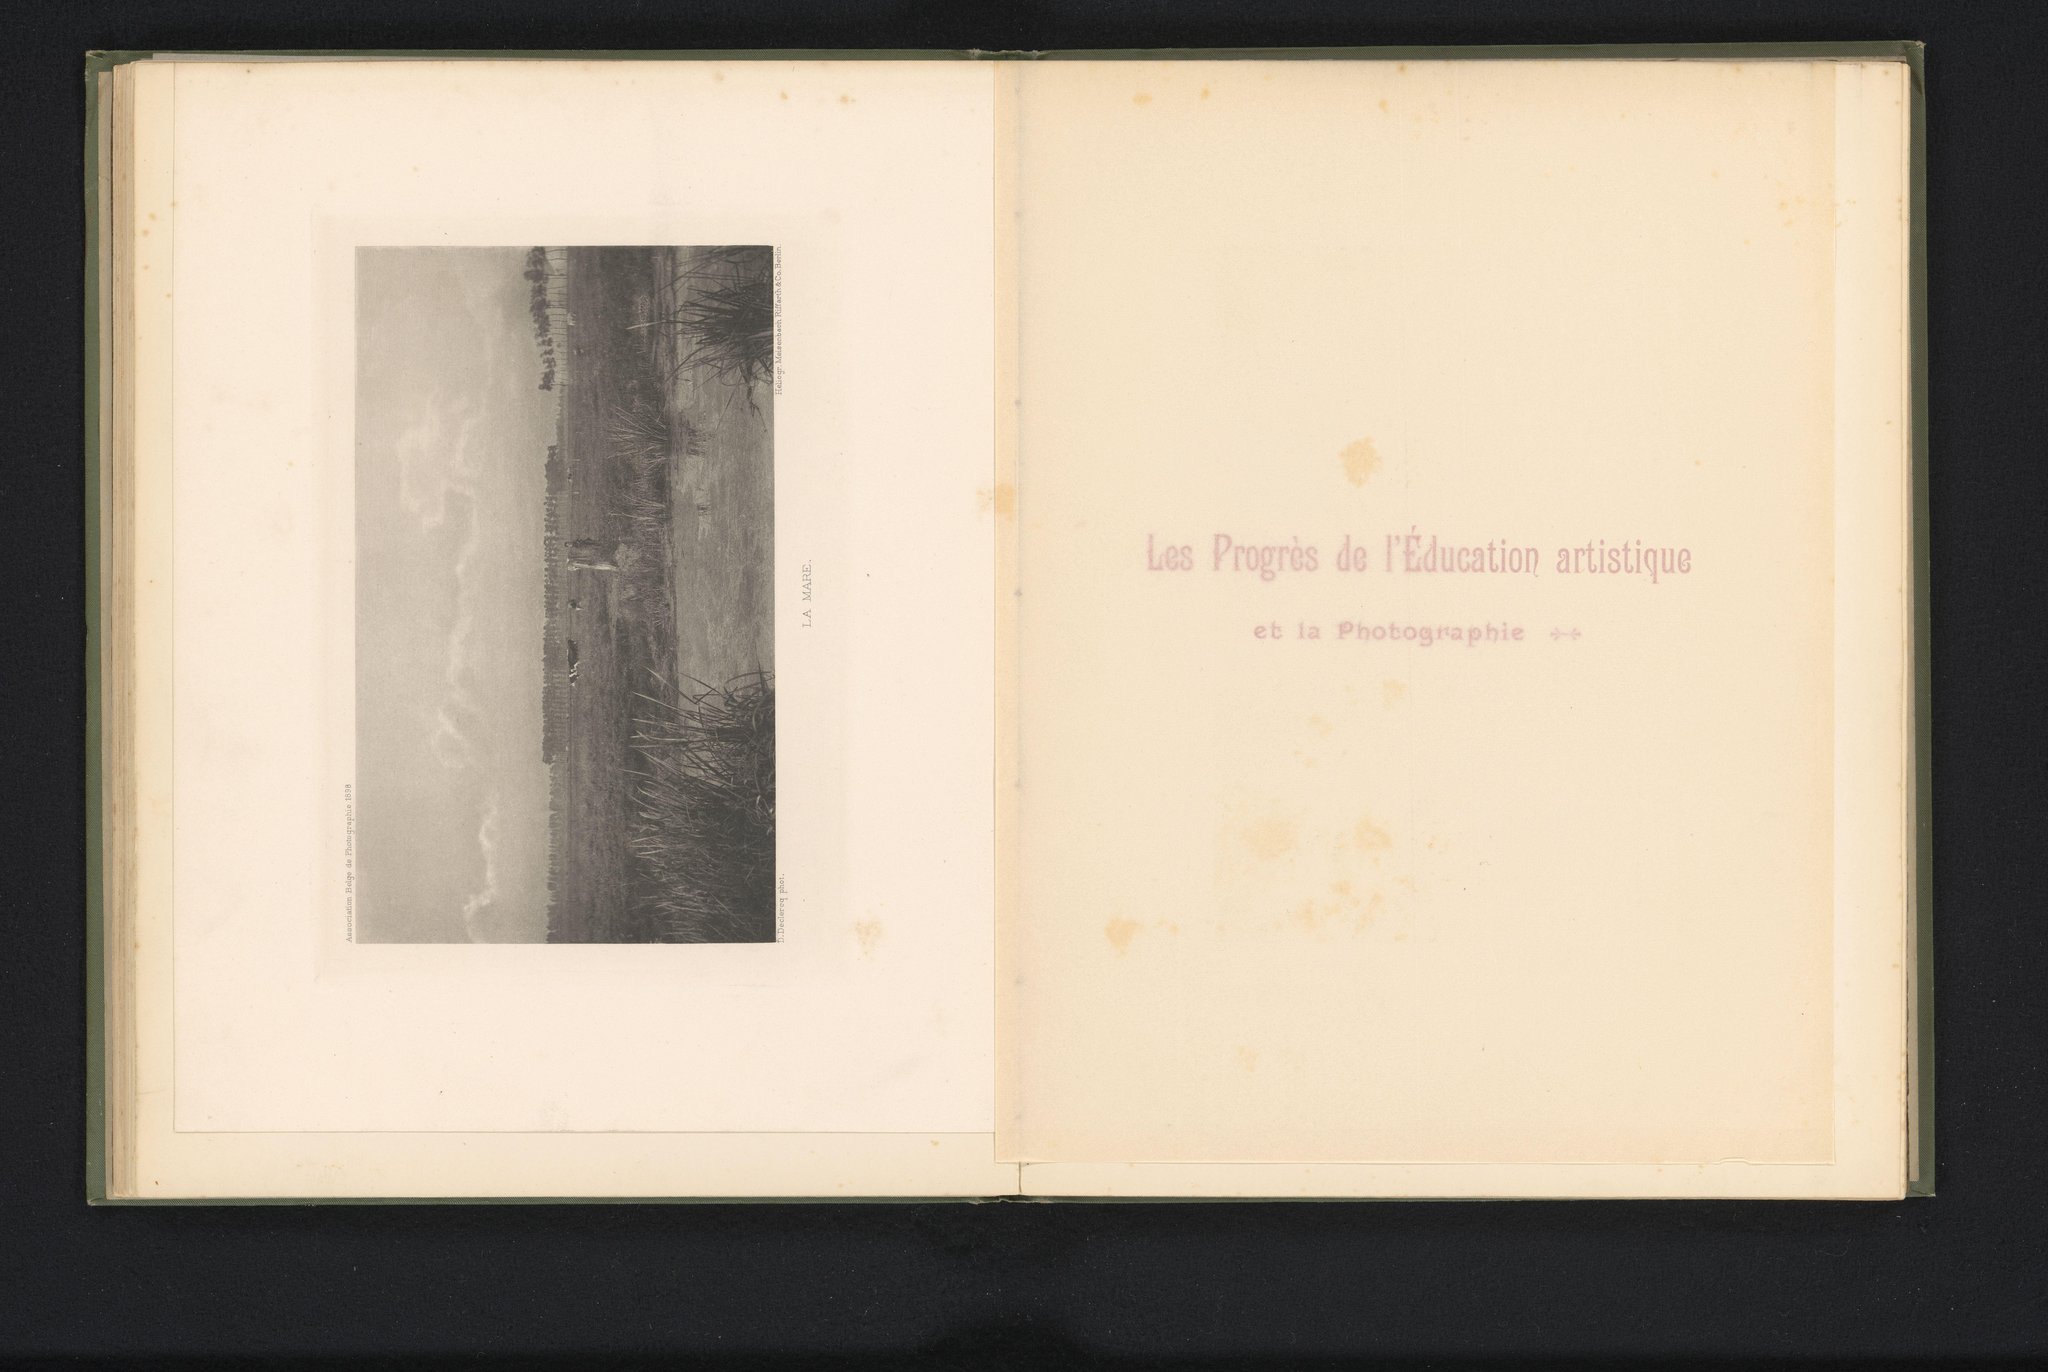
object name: photomechanical print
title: Koeien in de wei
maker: désiré declercq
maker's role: fotograaf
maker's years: 1842-1923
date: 1893-1898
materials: paper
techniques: photoaquatint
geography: berlin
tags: cow, landscapes, meadow, pasture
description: Prent op derde ongenummerde pagina na pagina 61.